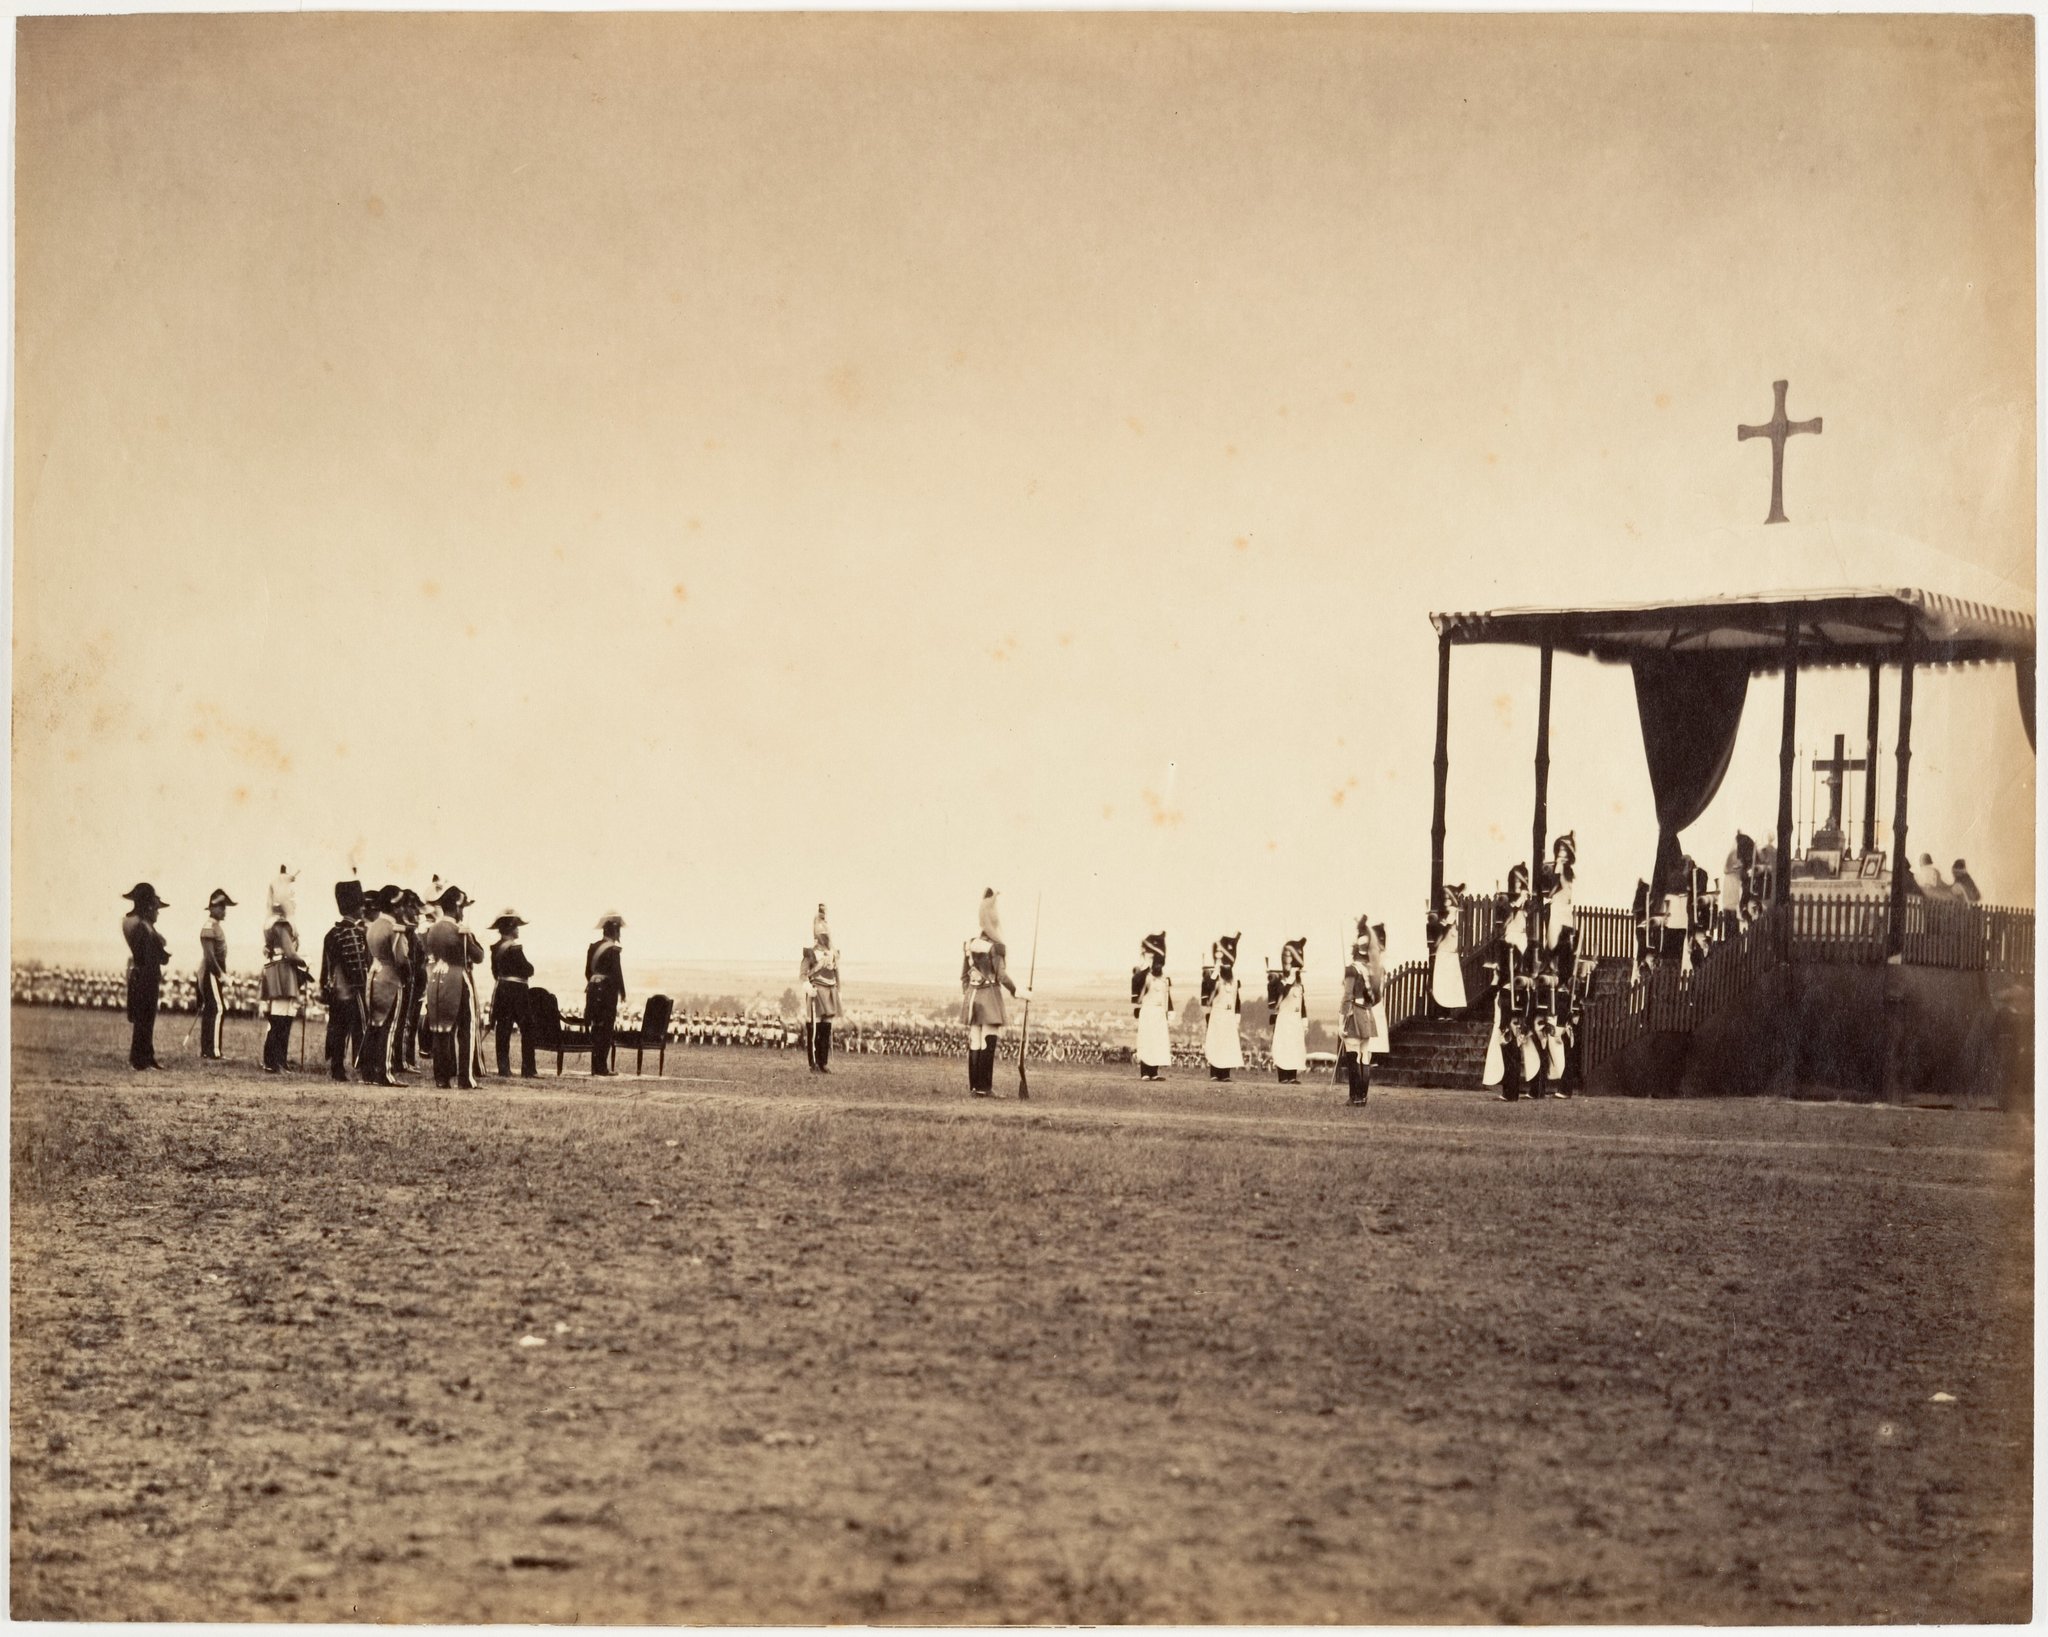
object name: photograph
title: La Messe au Camp de Châlons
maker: gustave le gray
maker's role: artist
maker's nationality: french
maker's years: 1820-1884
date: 1857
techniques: albumen silver print, glass negative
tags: altars,soldiers,men